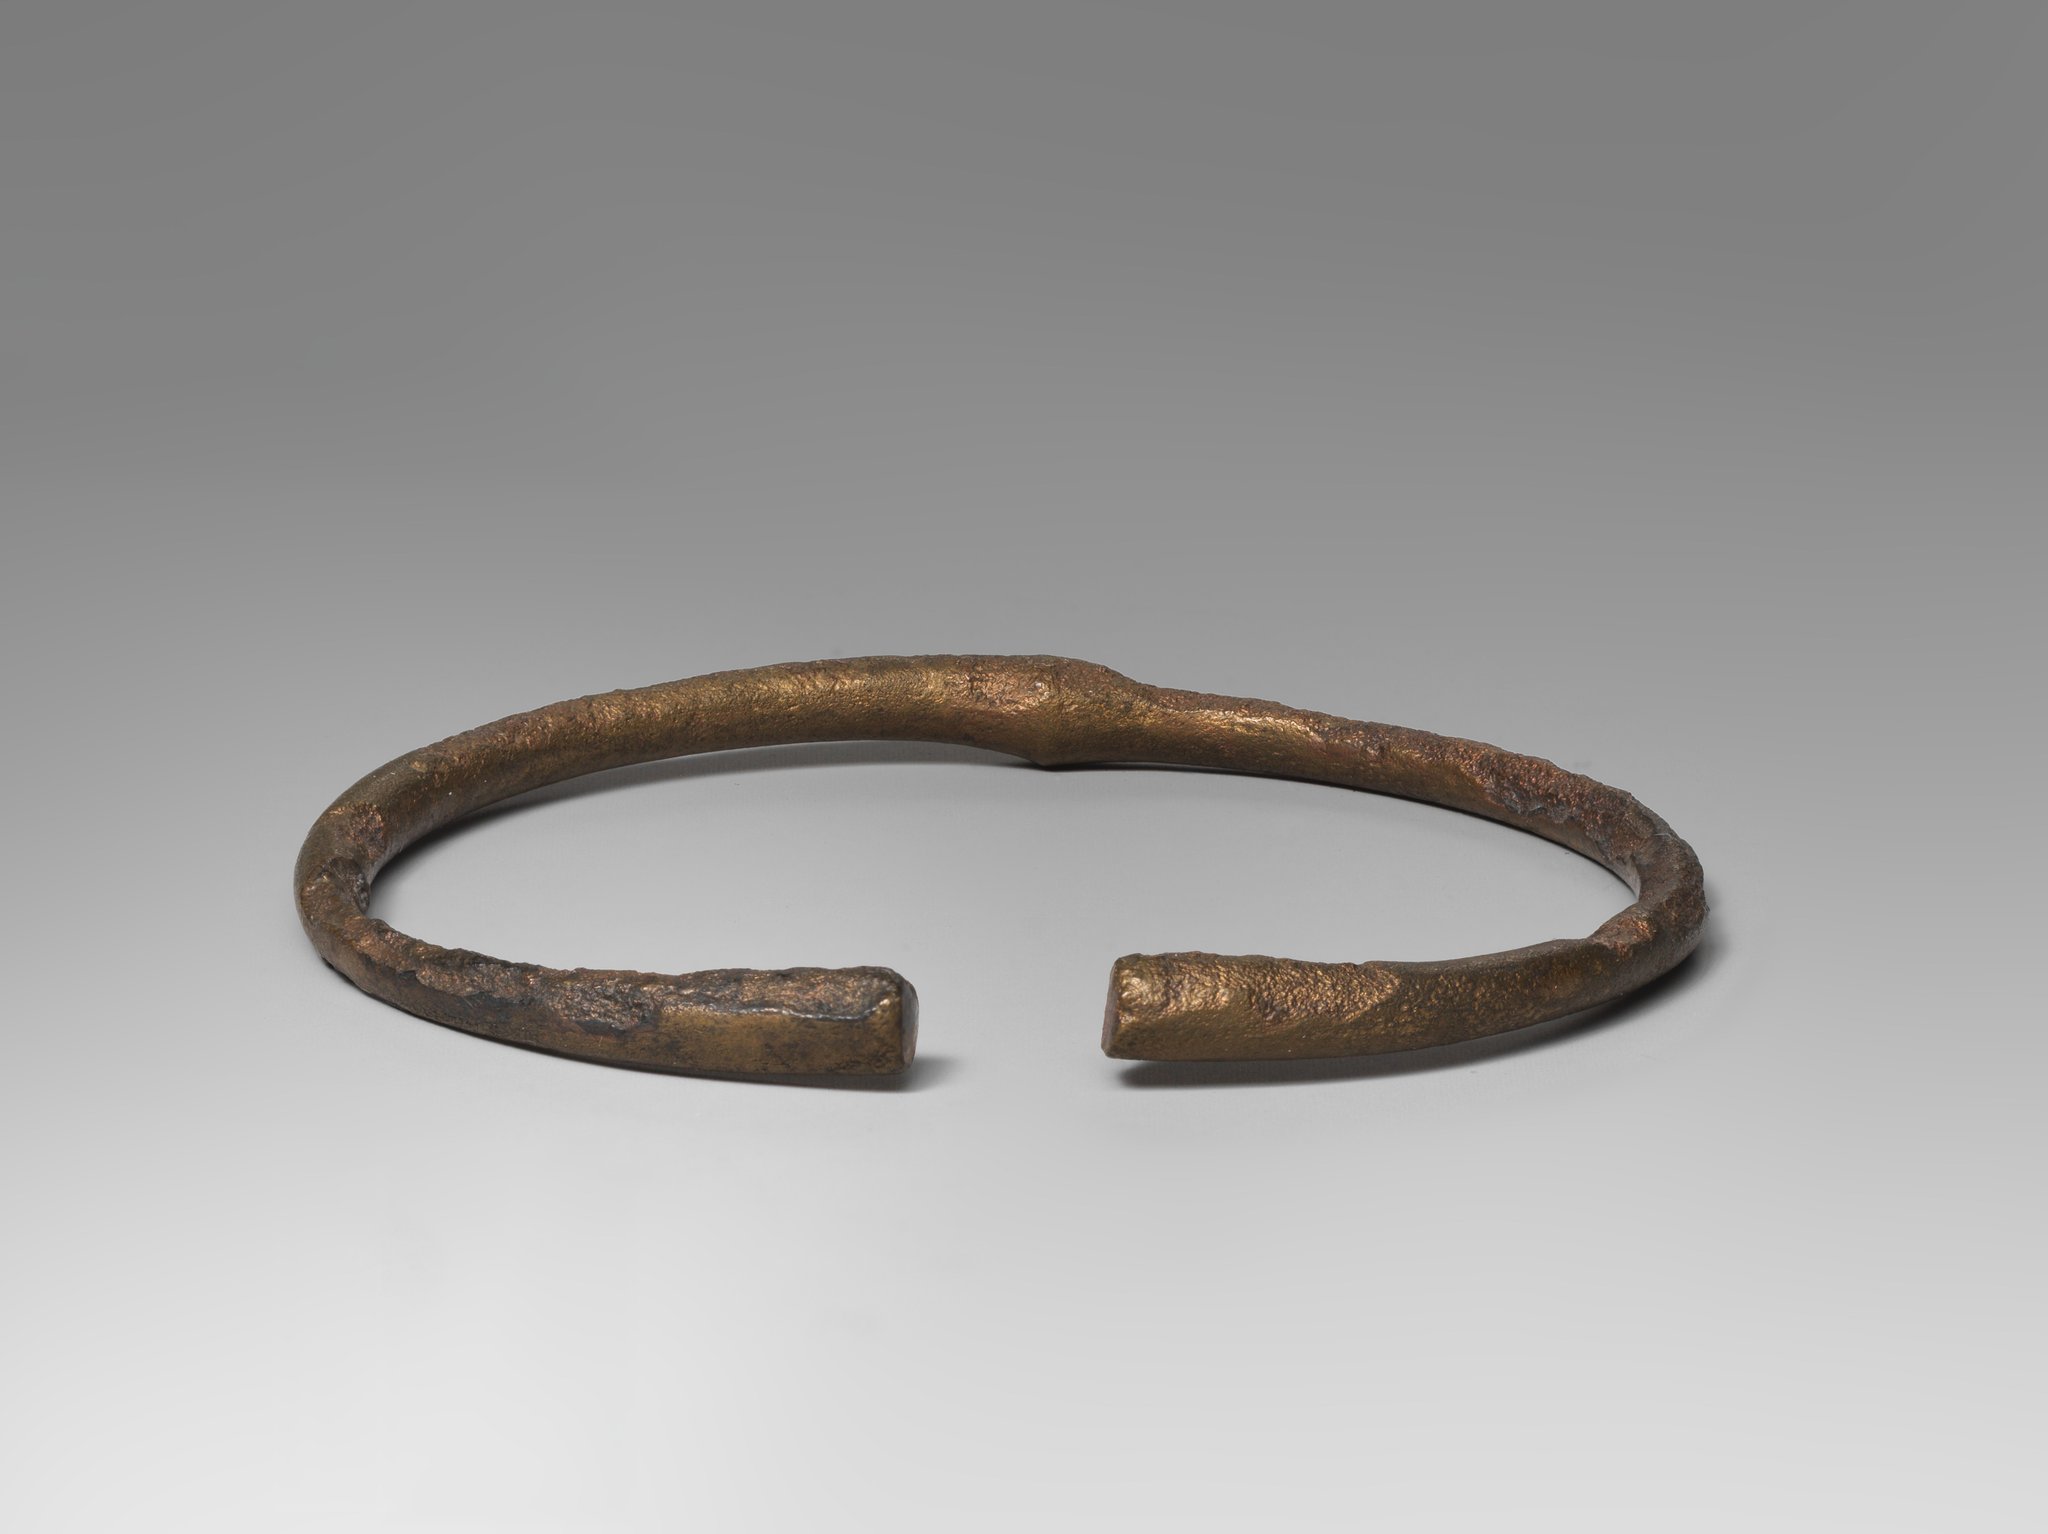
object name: bracelet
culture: sasanian or islamic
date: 501-800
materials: bronze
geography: iran